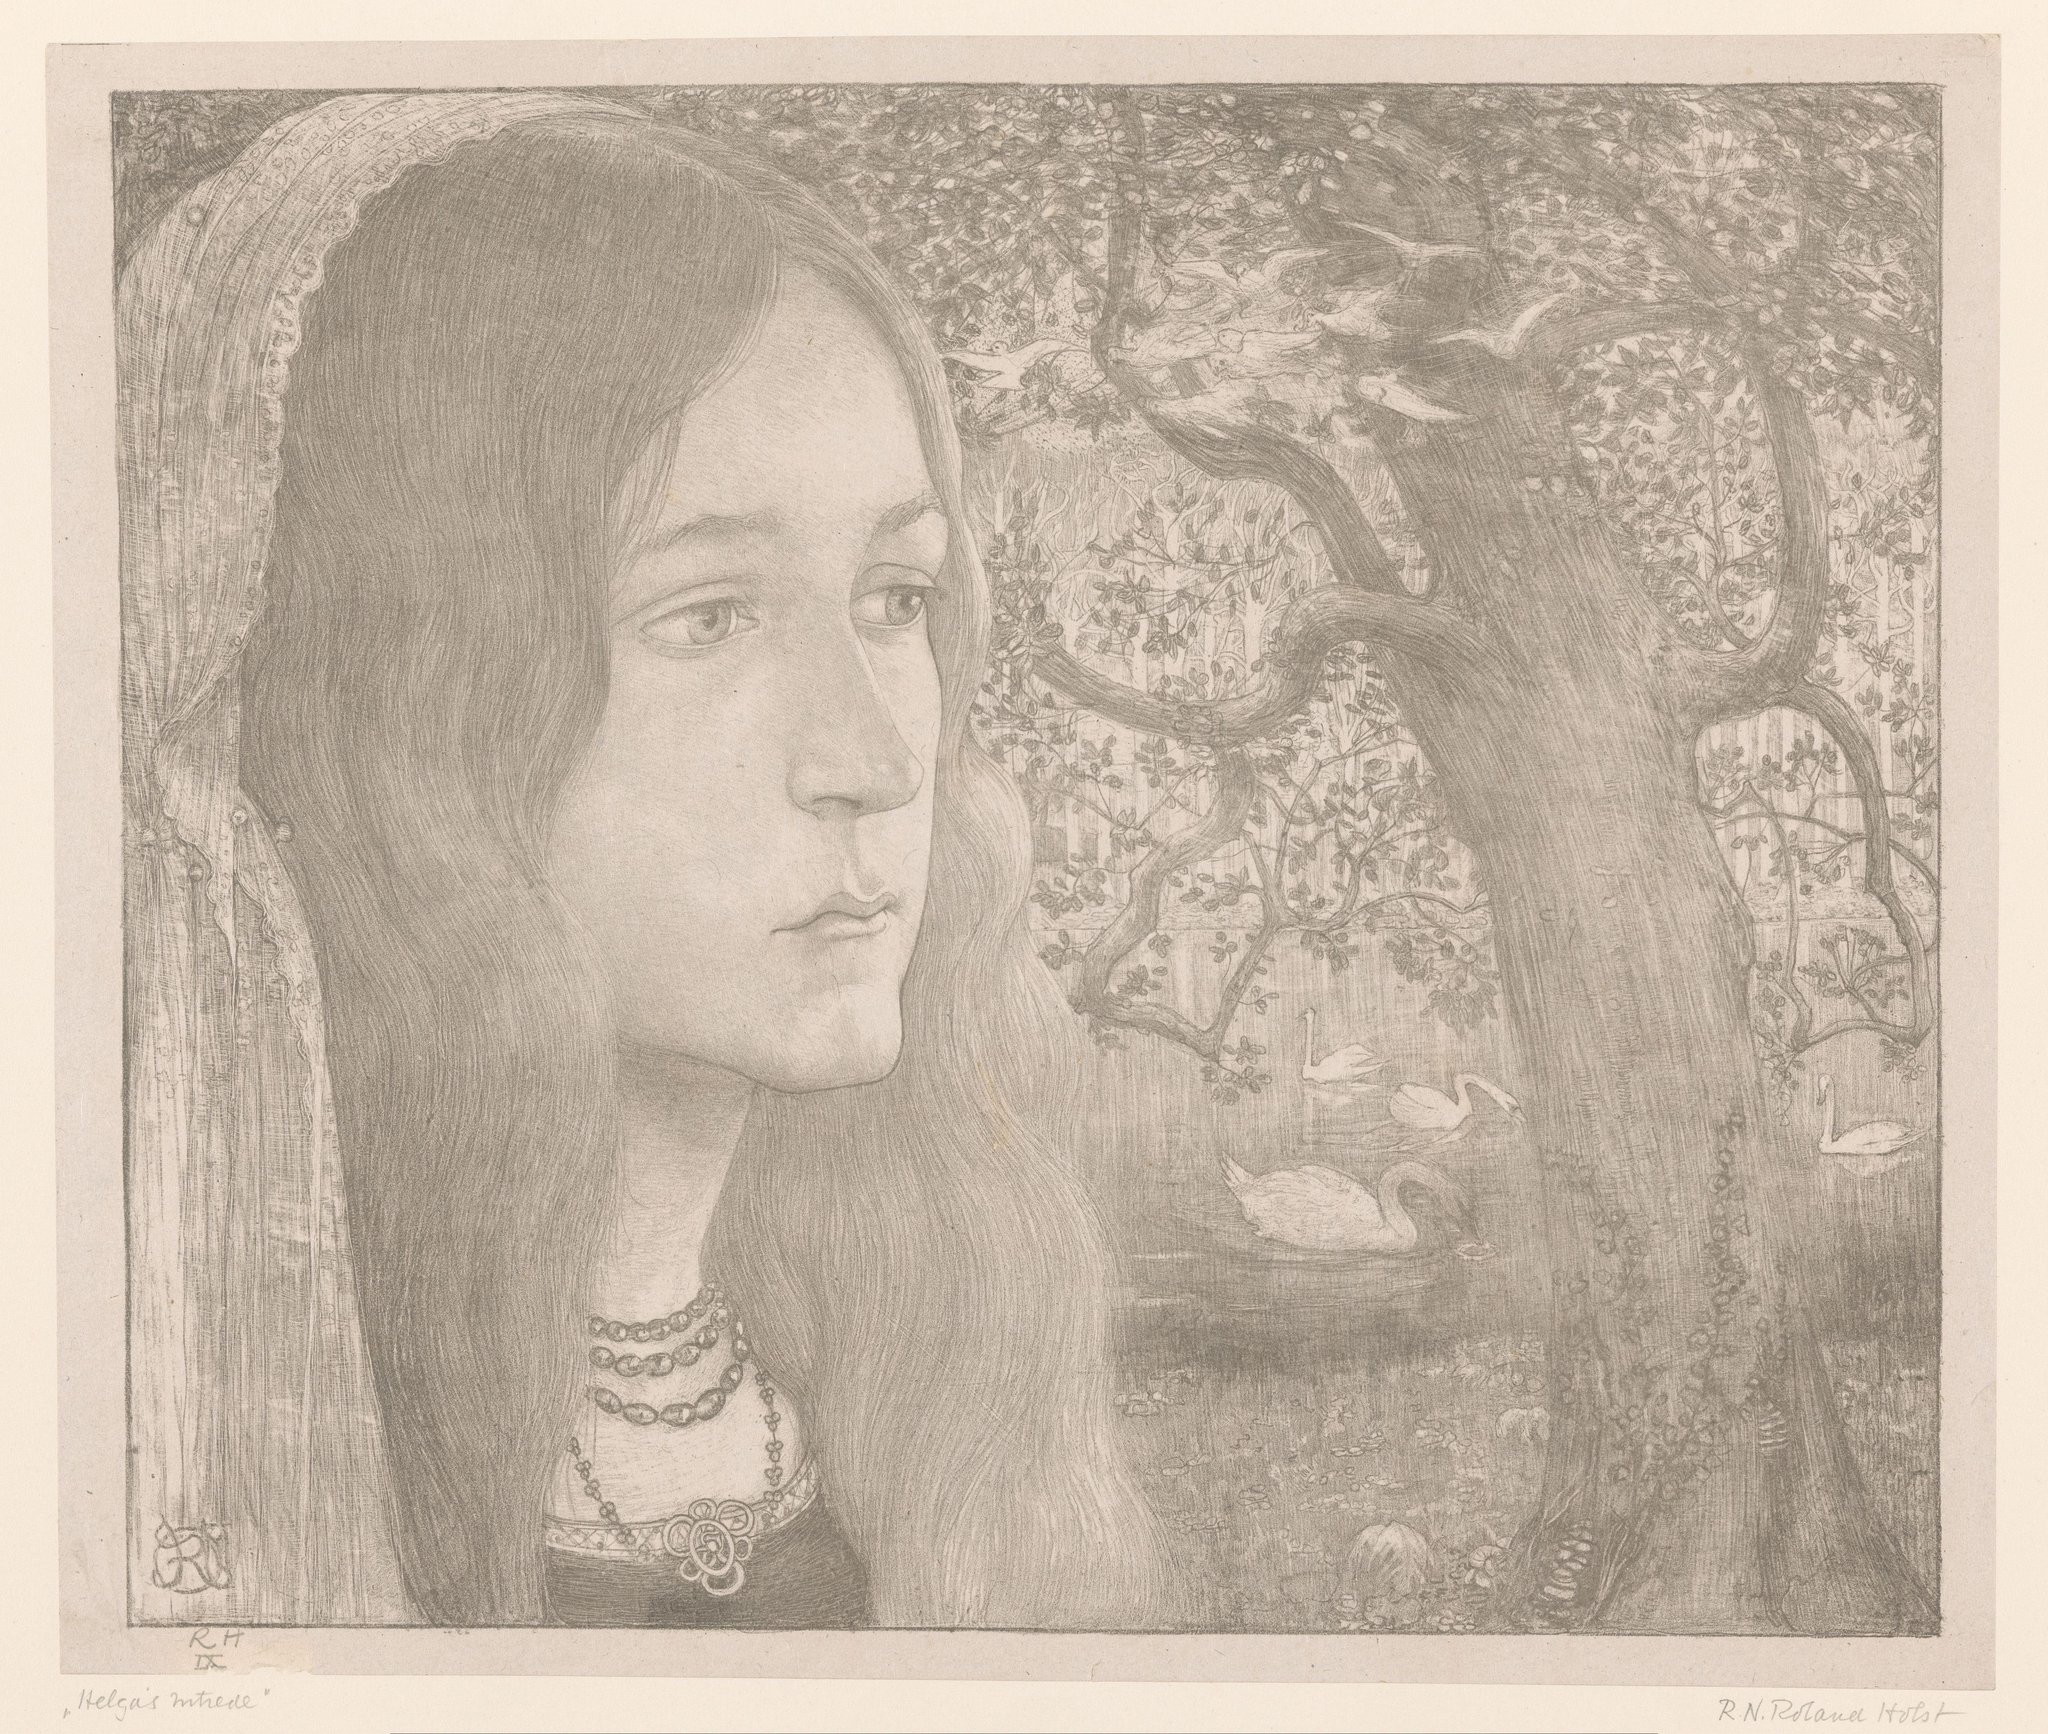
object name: print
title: Helga's intrede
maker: richard nicolaüs roland holst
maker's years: 1868-1938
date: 1893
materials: paper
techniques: lithograph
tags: adolescent, young woman, maiden, trees, water-birds: swan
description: Prent geïnspireerd op de IJslandse saga van Gunnlaug Slangentong. In de saga dingen zowel Gunnlaug Slangentong en Raven de Skald om de hand van Helga. Beide mannen vinden uiteindelijk de dood.